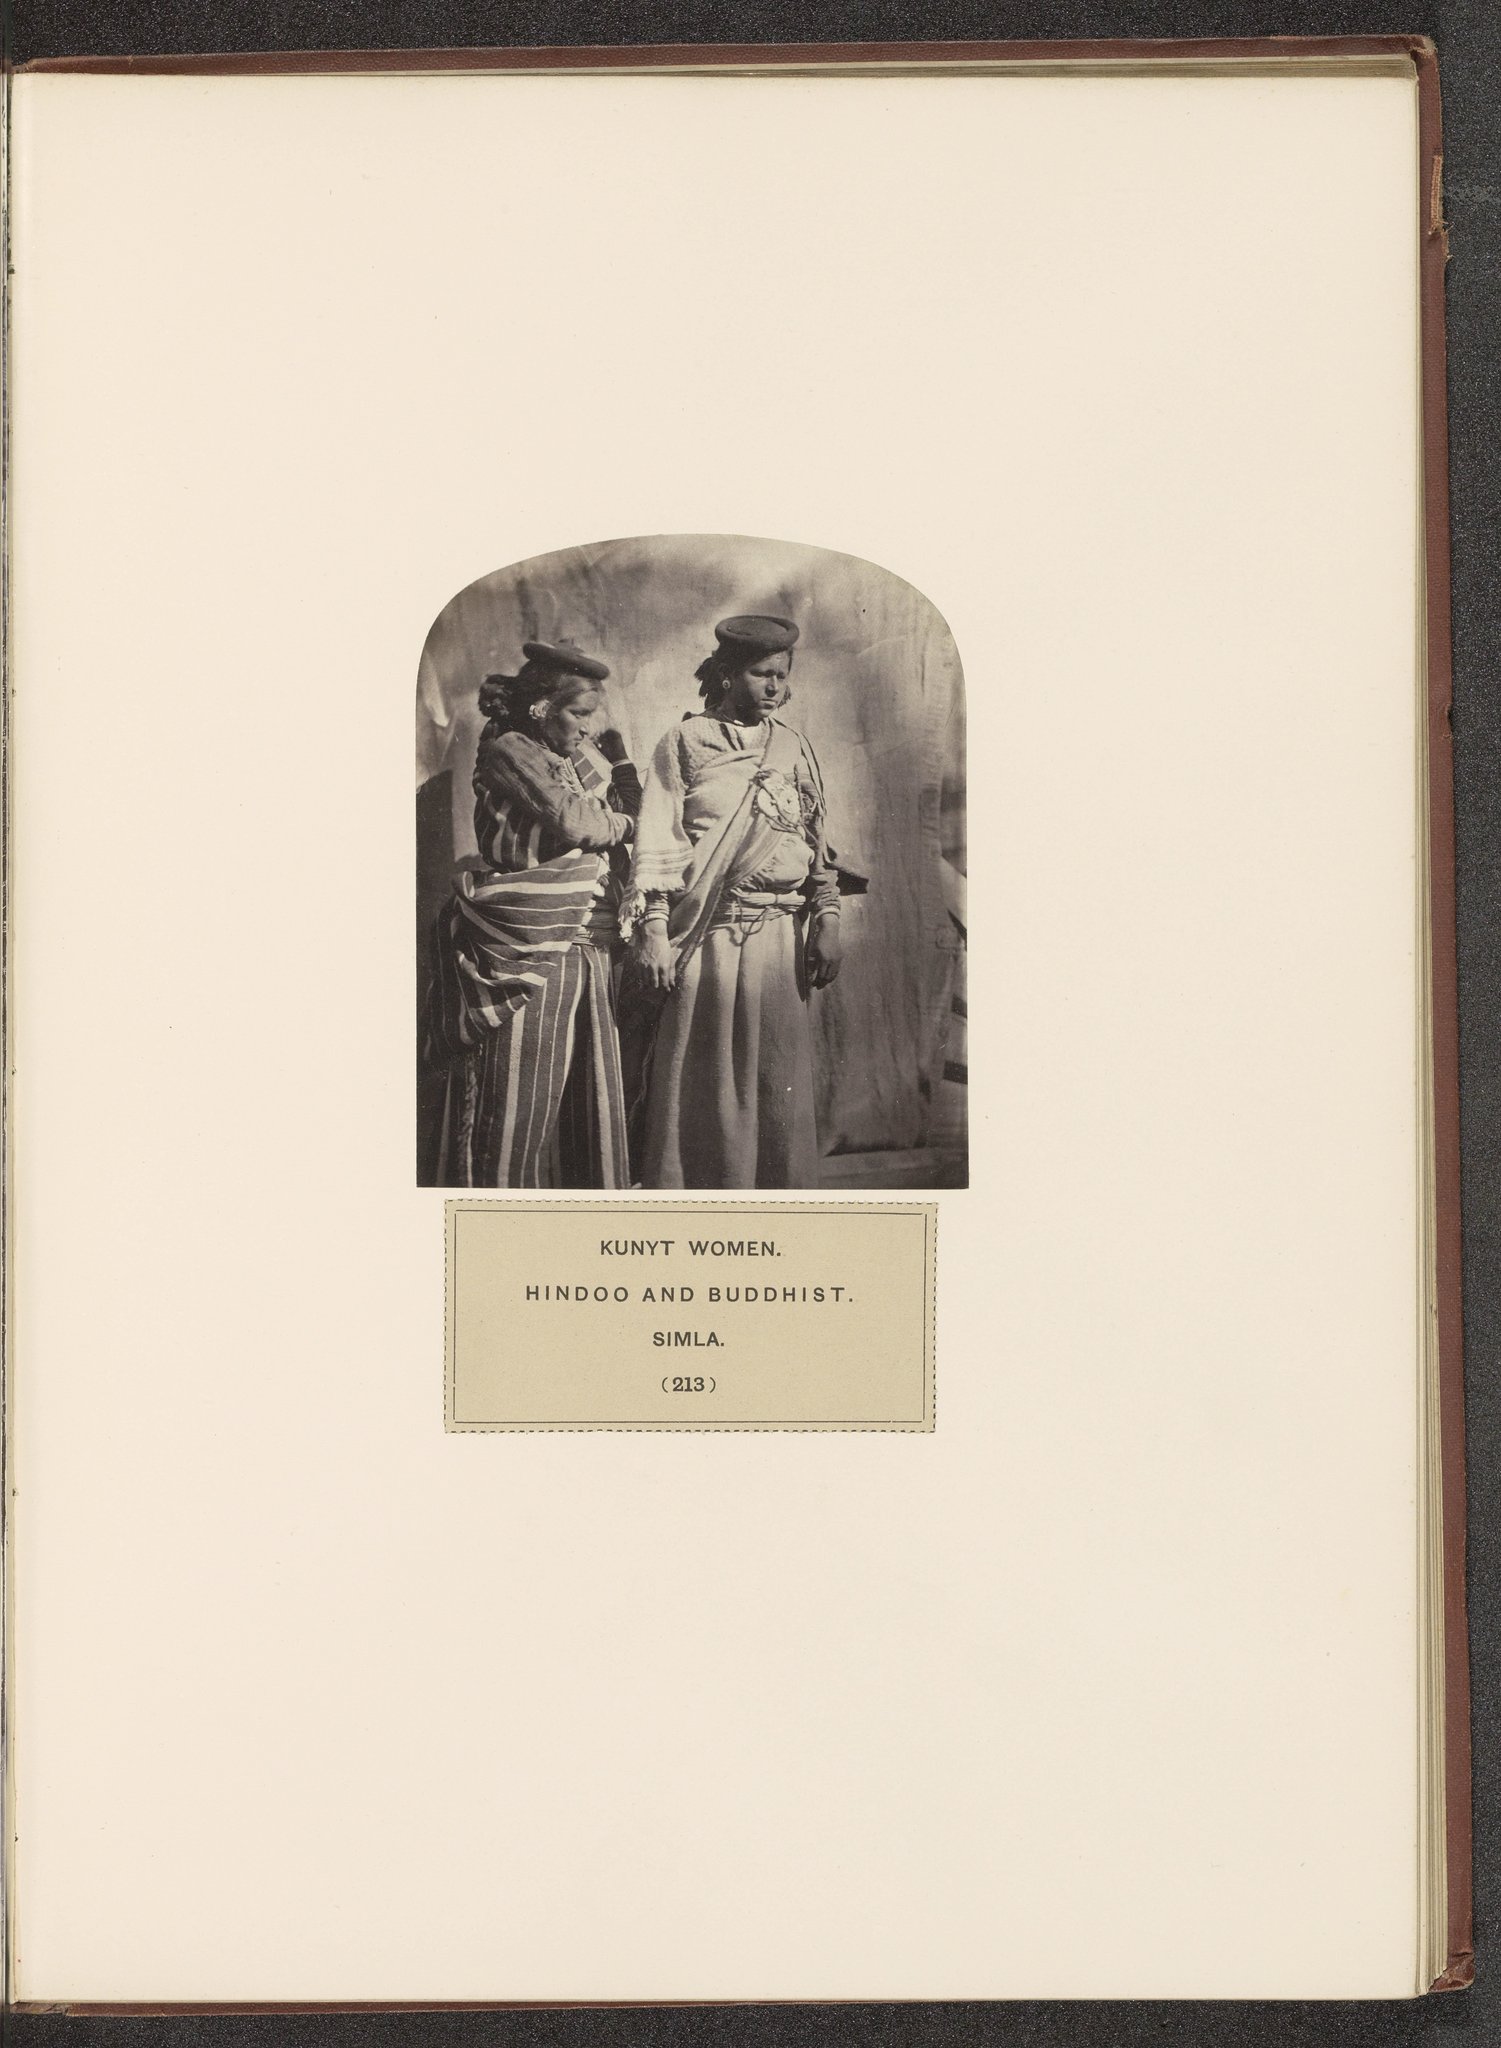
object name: page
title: Two unknown women in traditional dresses from the Kanet community of Shimla, Himachal Pradesh, India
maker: Anonymous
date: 1859-1869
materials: photographic support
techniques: albumen print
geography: shimla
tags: folk costume, regional costume, human races; peoples; nationalities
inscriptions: number: ‘(213)’, inscription: ‘KUNYT WOMEN./ HINDOO AND BUDDHIST./ SIMLA.’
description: De Kanet-gemeenschap is ook bekend als Kunait.